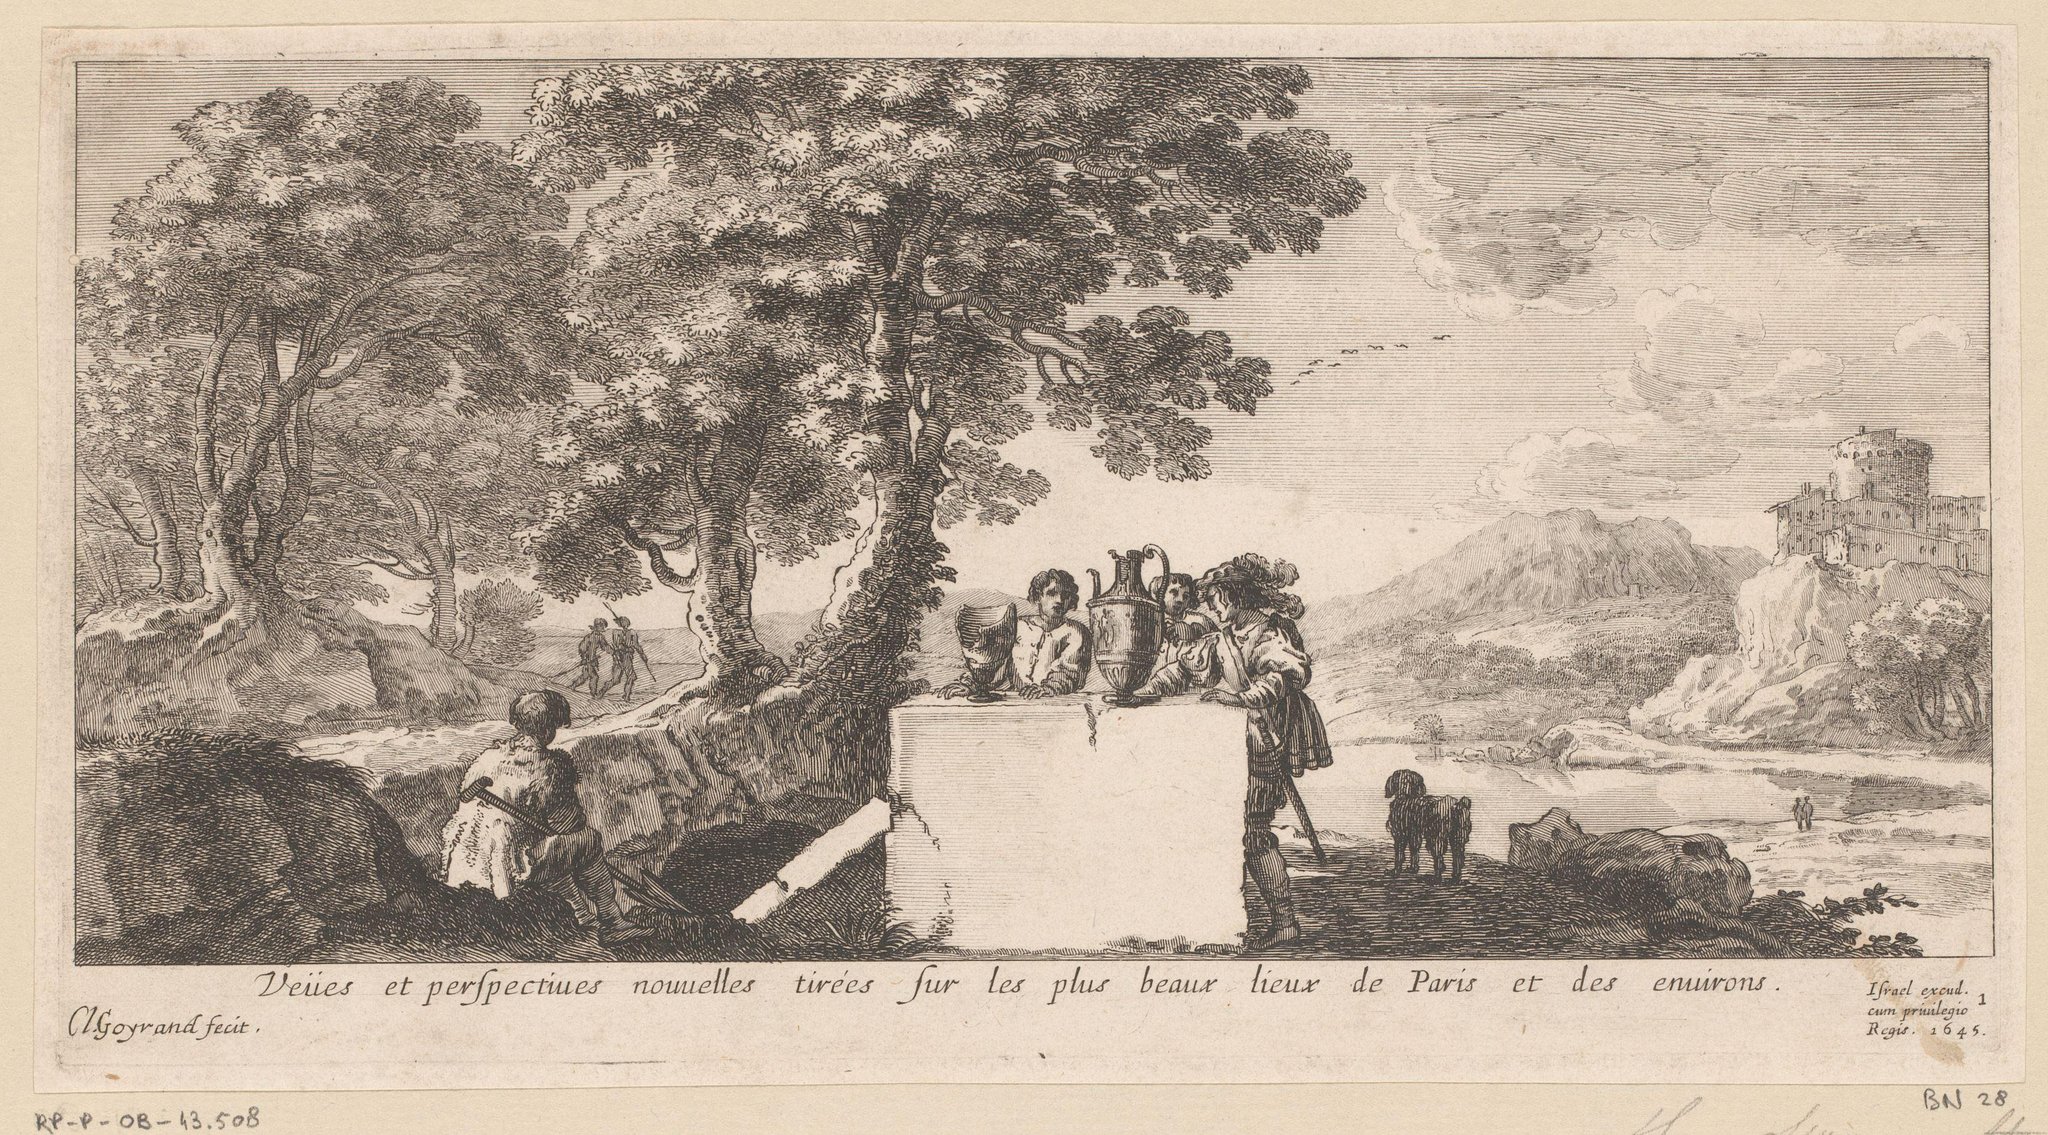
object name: titelprent, frontispice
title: Titelprent met figuren bij een altaar met twee gebroken vazen in een rivierlandschap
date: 1645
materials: paper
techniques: etching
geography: paris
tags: landscape with ruins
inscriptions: collector's mark: Lugt 240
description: Titelprent van een achtdelige serie getiteld 'Diverses Veuës et Perspectives nouvelles de Rome, Paris et des autres lieux'. De serie werd volgens IFF 17e siècle, p. 22, voor het eerst uitgegeven in 1644 in Parijs.